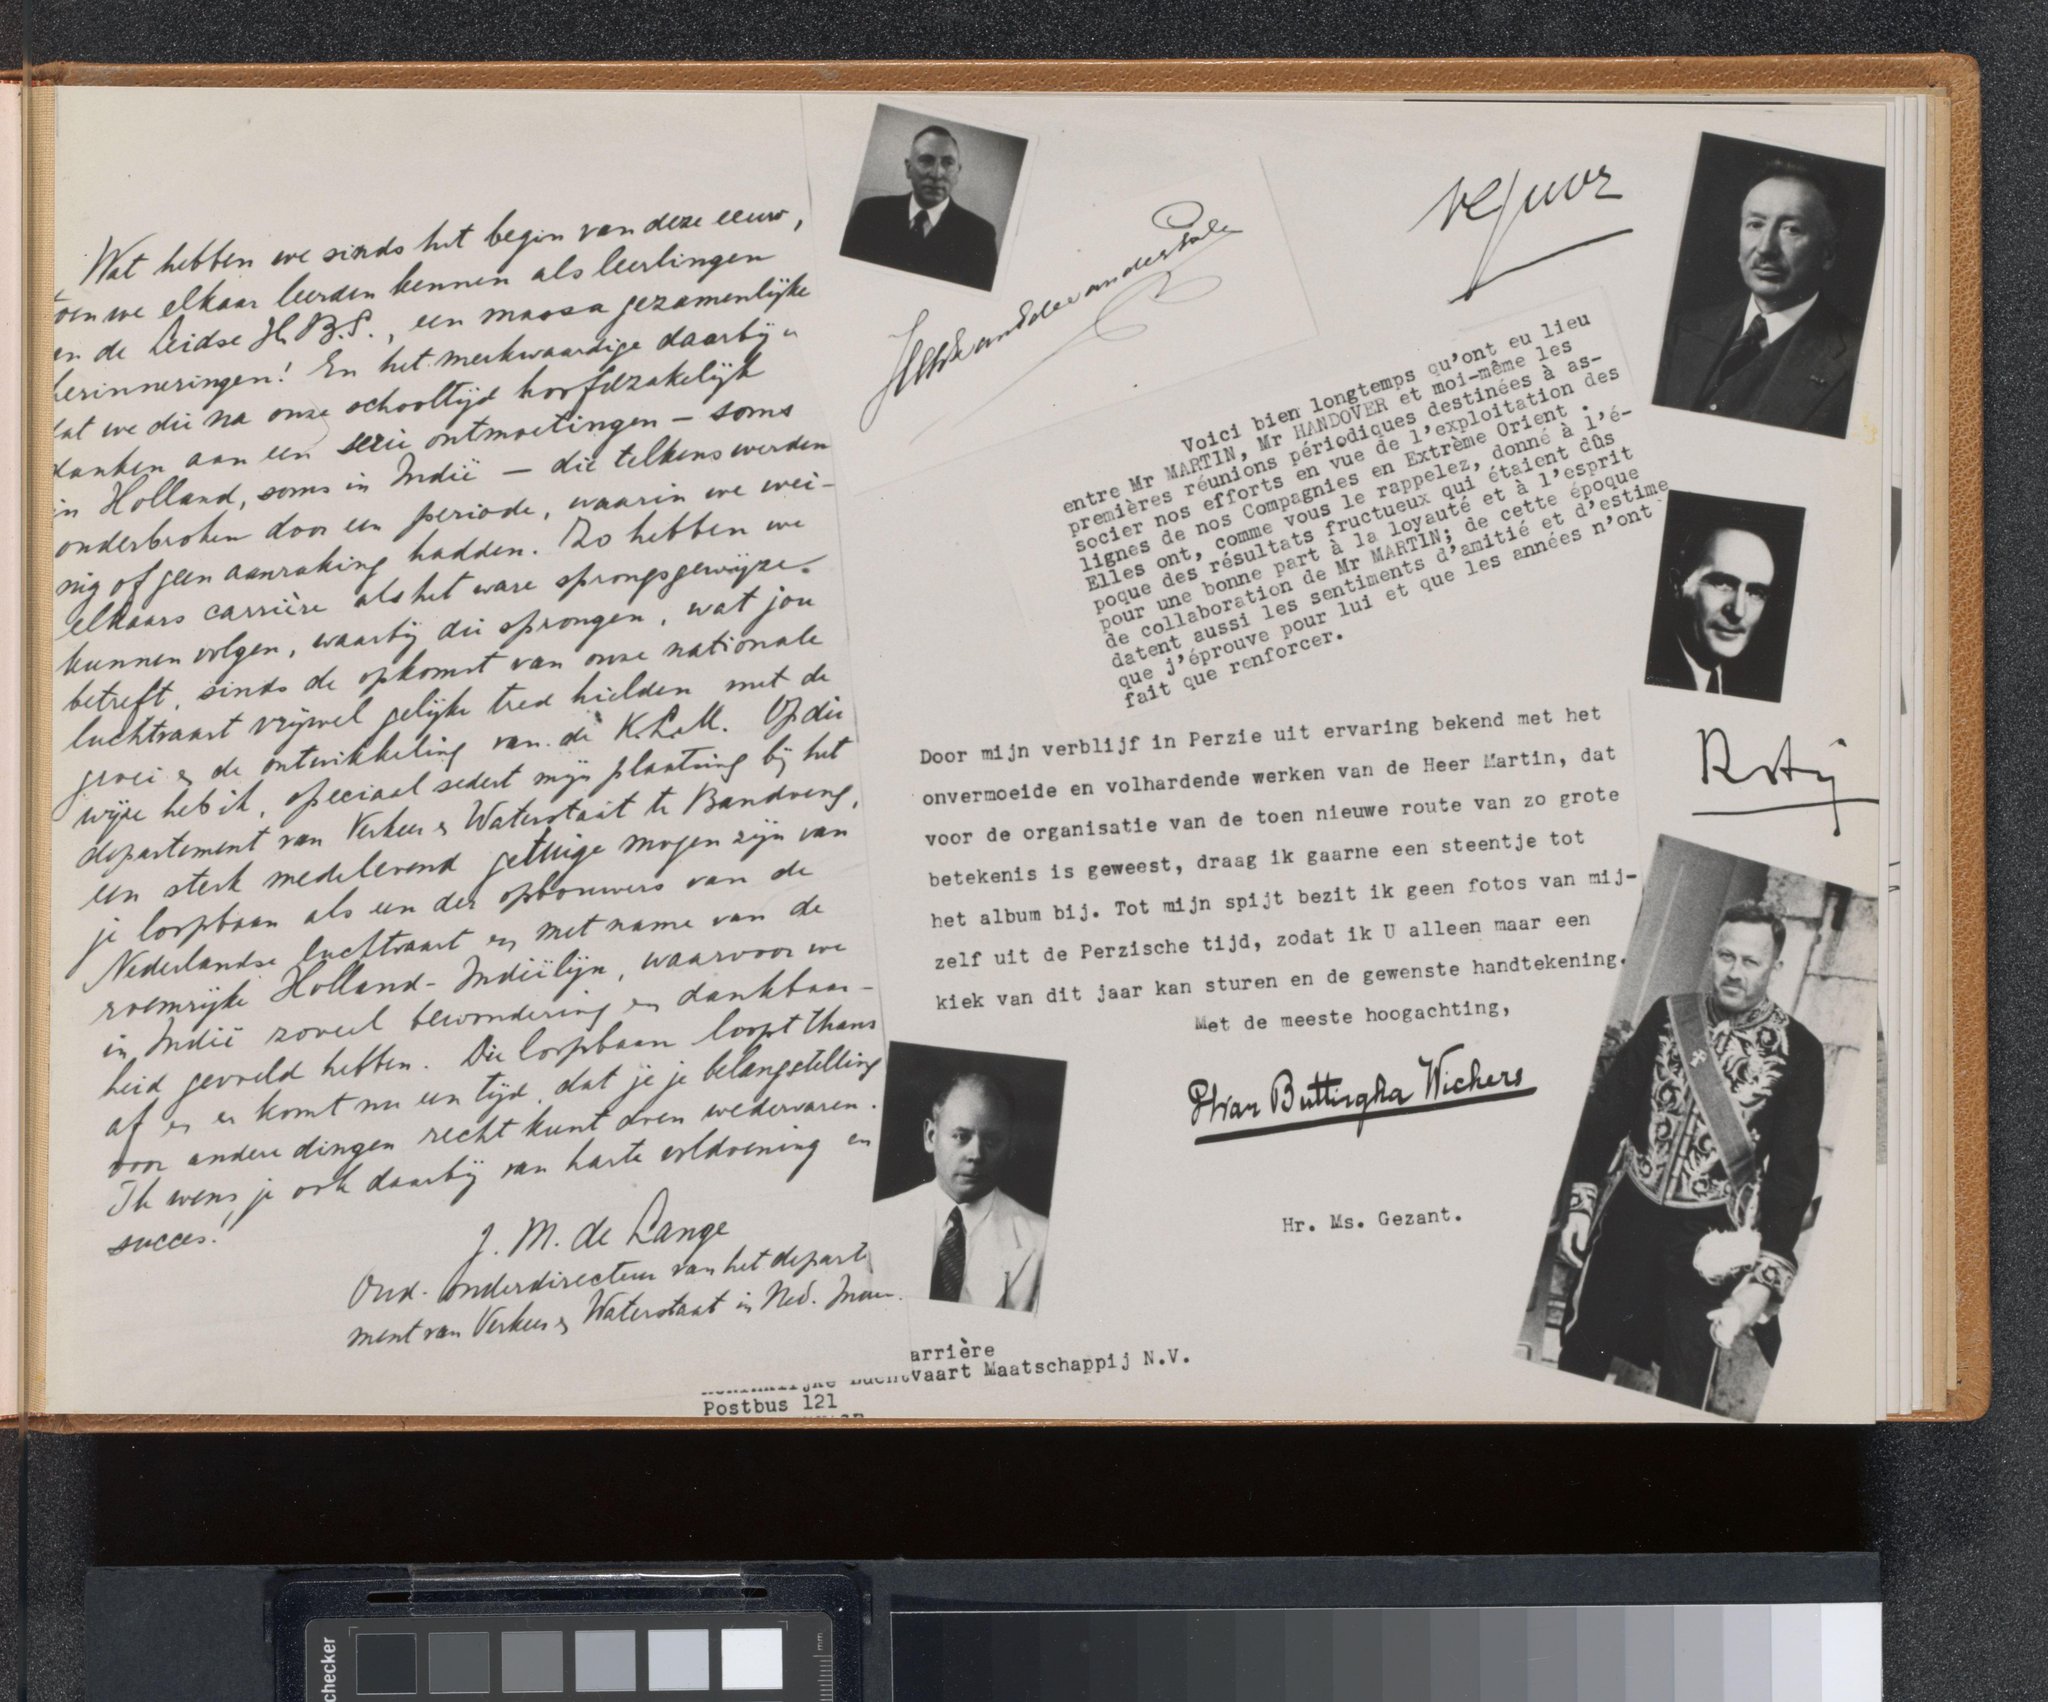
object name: photomontage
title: Brieven en foto's zakenrelaties van Hans Martin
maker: Anonymous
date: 1949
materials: cardboard, paper, photographic support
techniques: gelatin silver print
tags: airborne traffic, aviation, travelling; tourism, letter, envelope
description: Albumblad met een compositiefoto van brieven van zakenrelaties van Hans Martin, de grondlegger van de Indië-lijn van de KLM, waarin zij hun erkentelijkheid uitdrukken voor zijn werk. Ook foto's van hen. Onderdeel van Herdenkingsalbum van de Indië-lijn van de KLM, deel II.